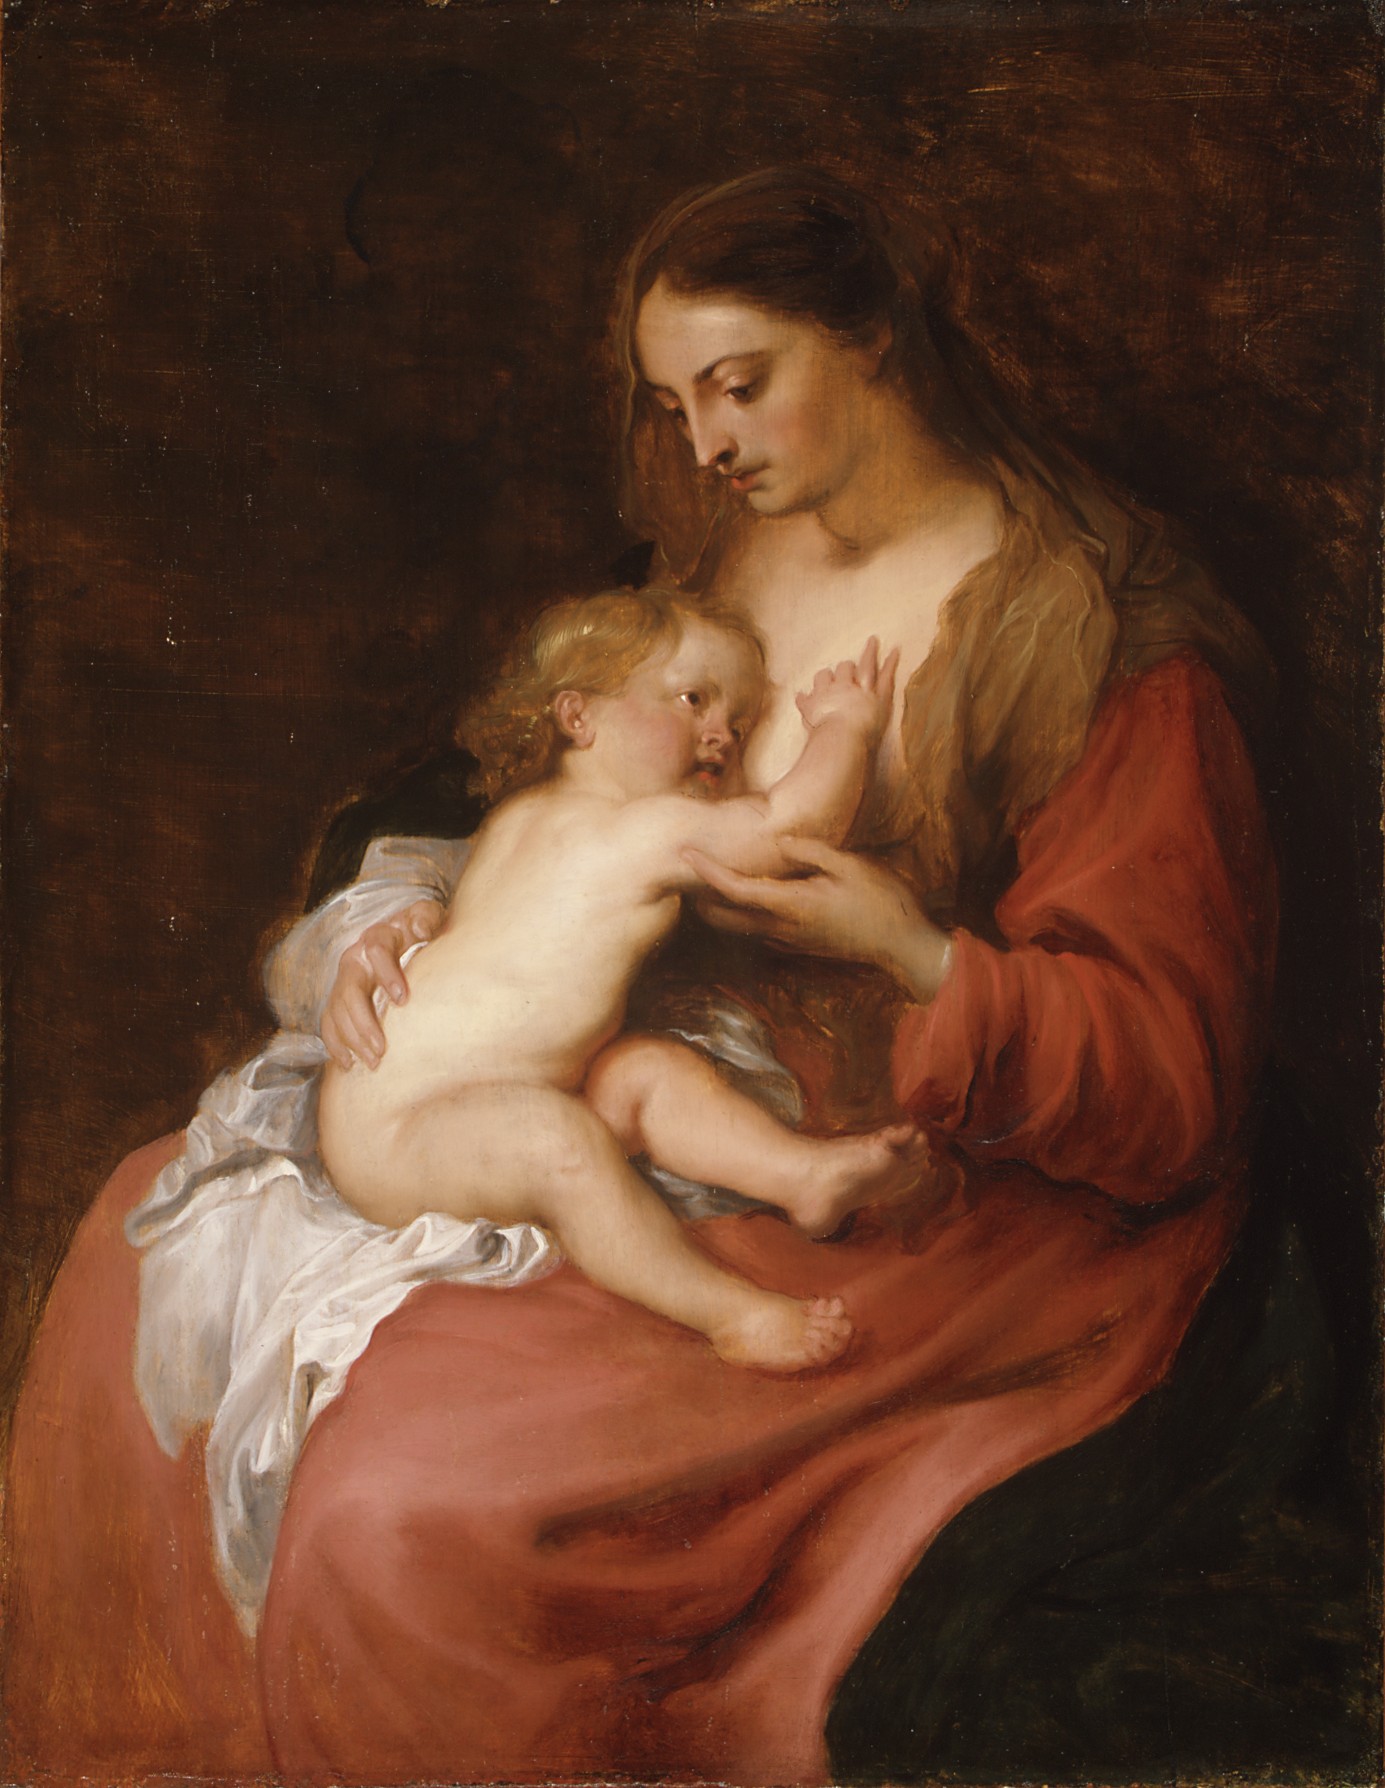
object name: painting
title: Virgin and Child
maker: anthony van dyck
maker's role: artist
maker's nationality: flemish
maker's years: 1599-1641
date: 1620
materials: oil, wood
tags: madonna and child,nursing